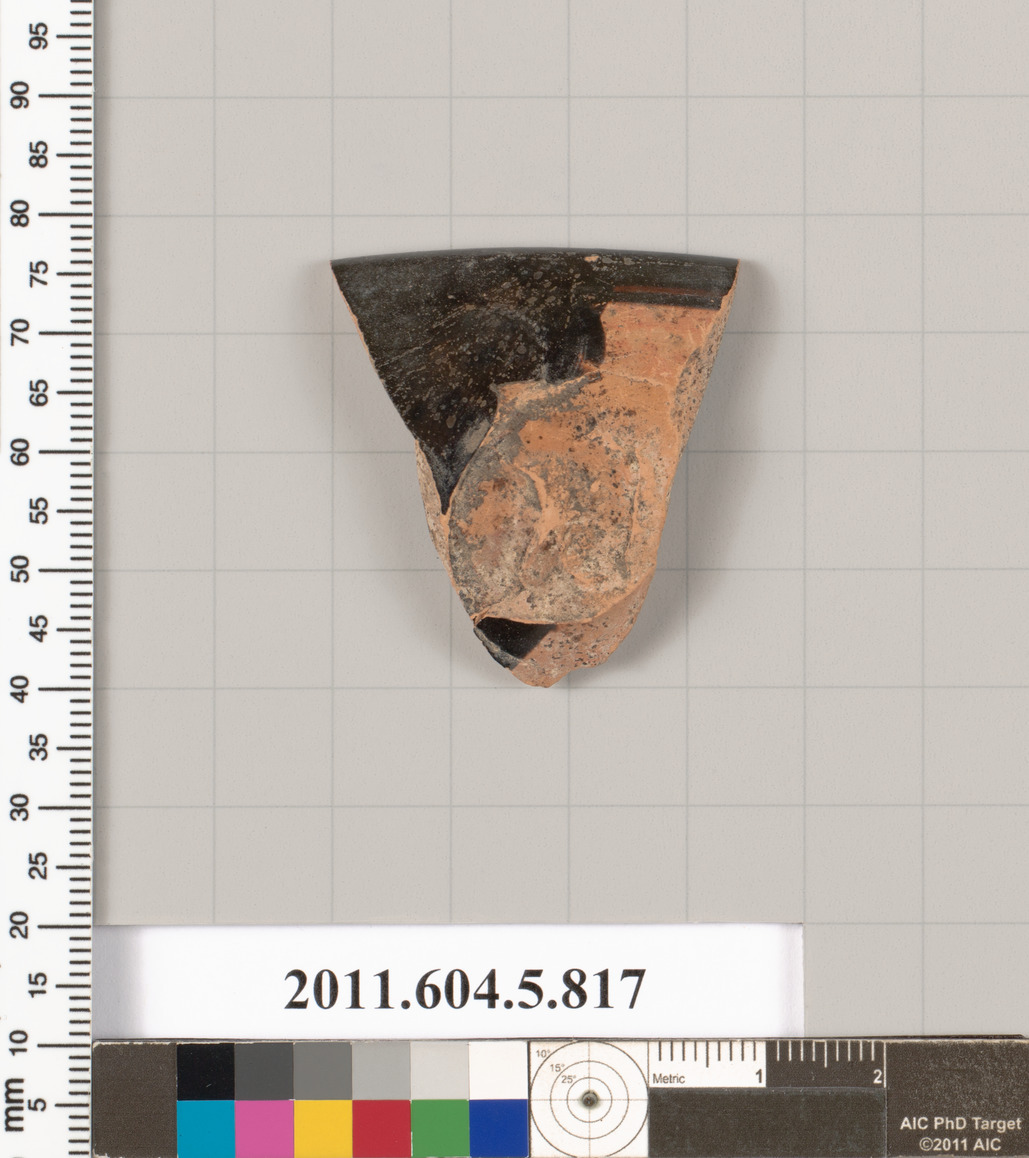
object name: kylix fragment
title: Terracotta rim fragment of a kylix (drinking cup)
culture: greek, attic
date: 600-401 BCE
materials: terracotta